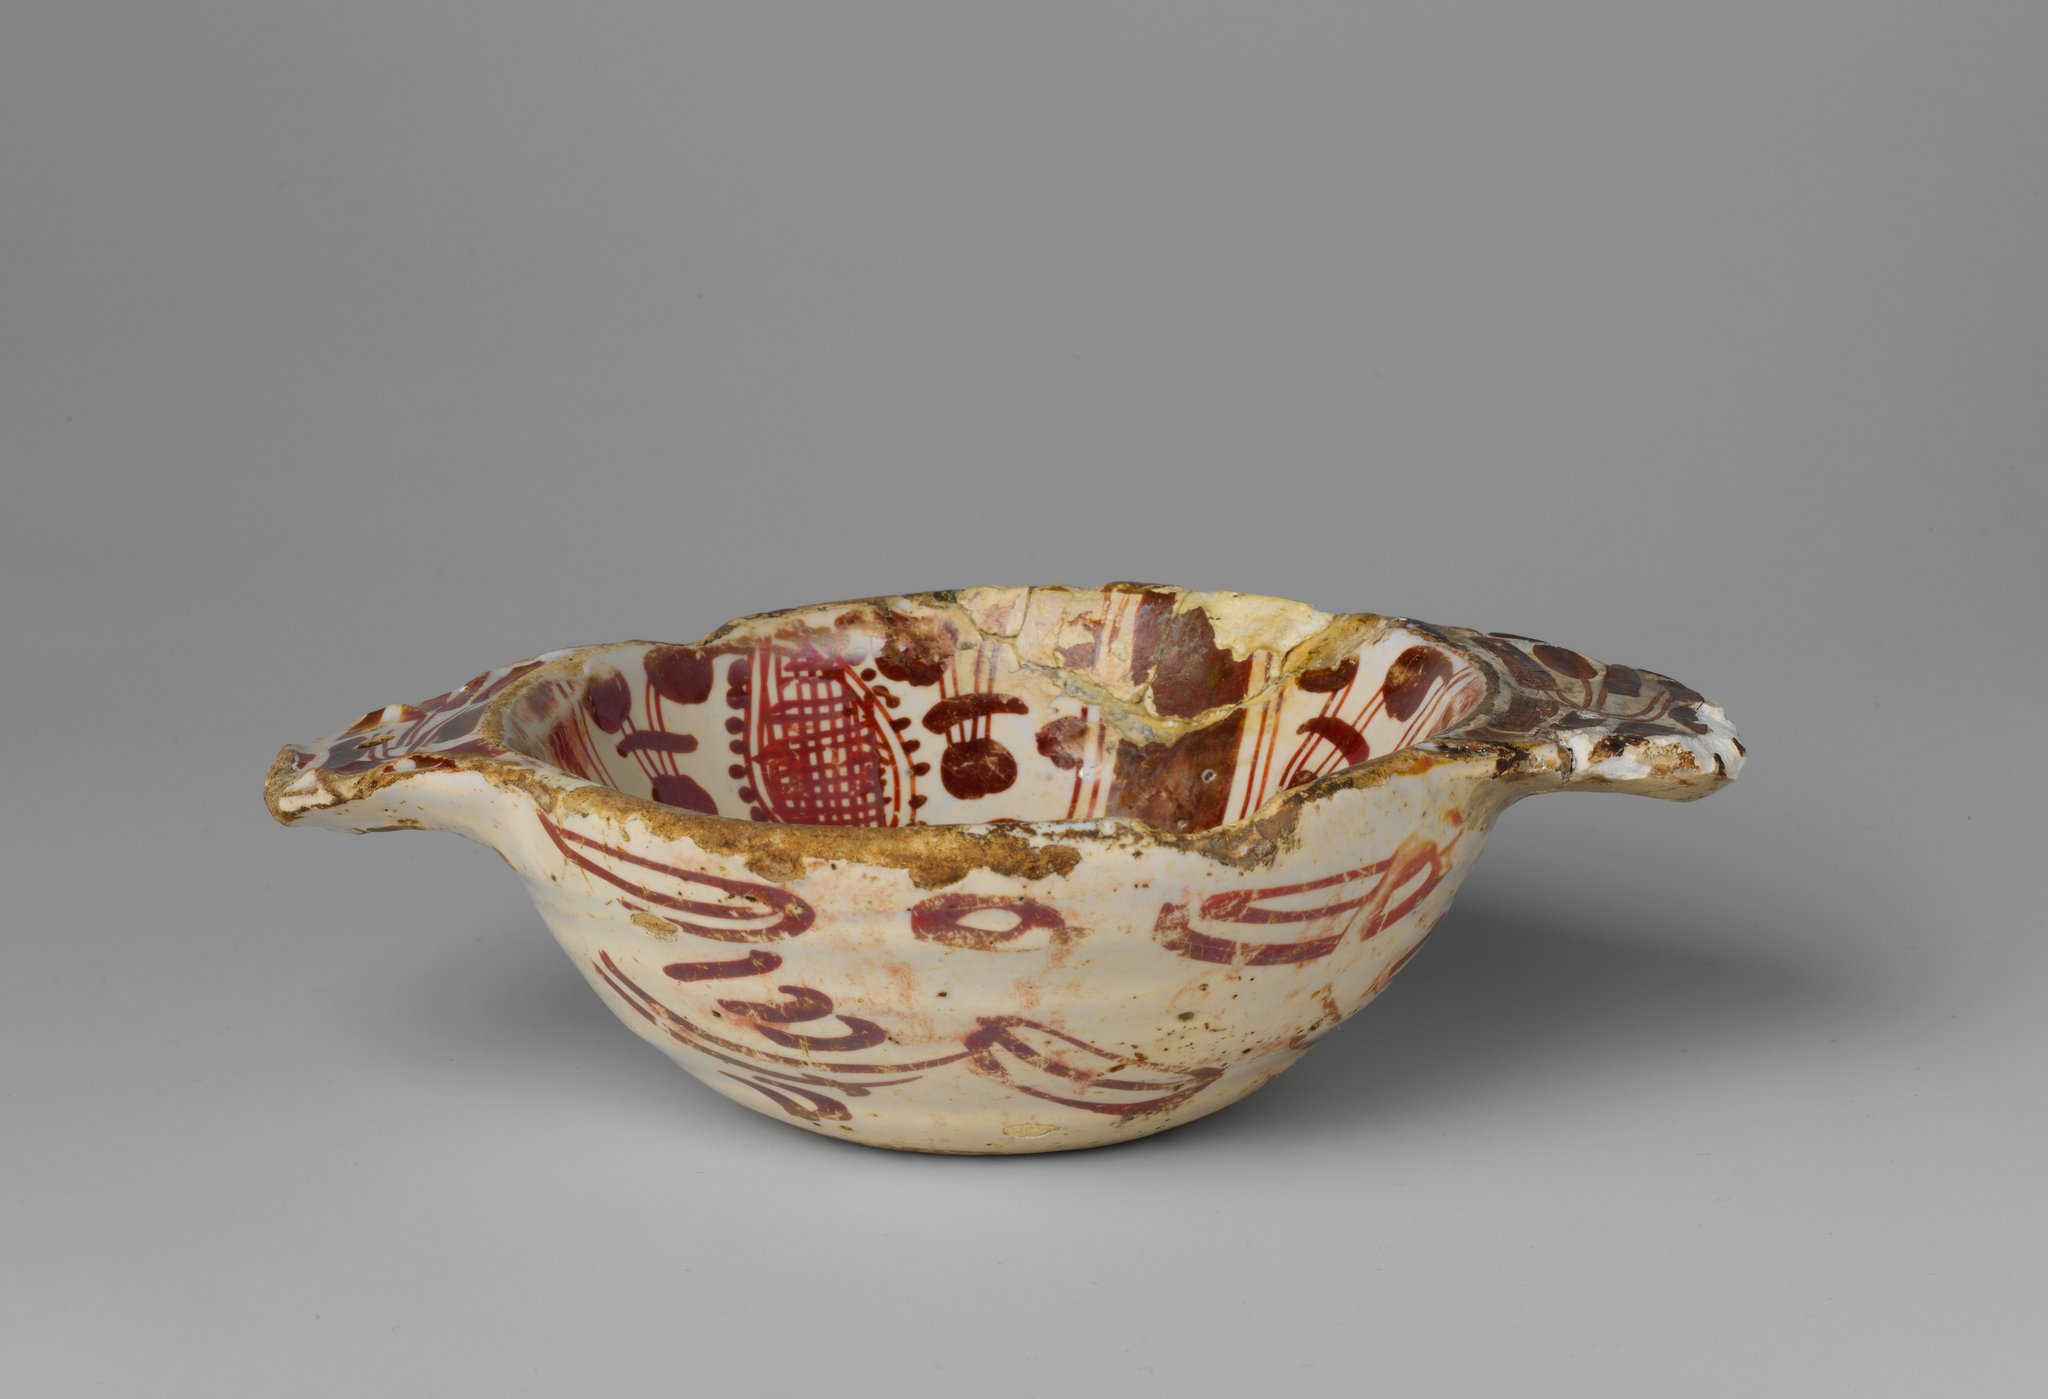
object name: scudello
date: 1501-1600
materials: earthenware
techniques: luster painting, glazing